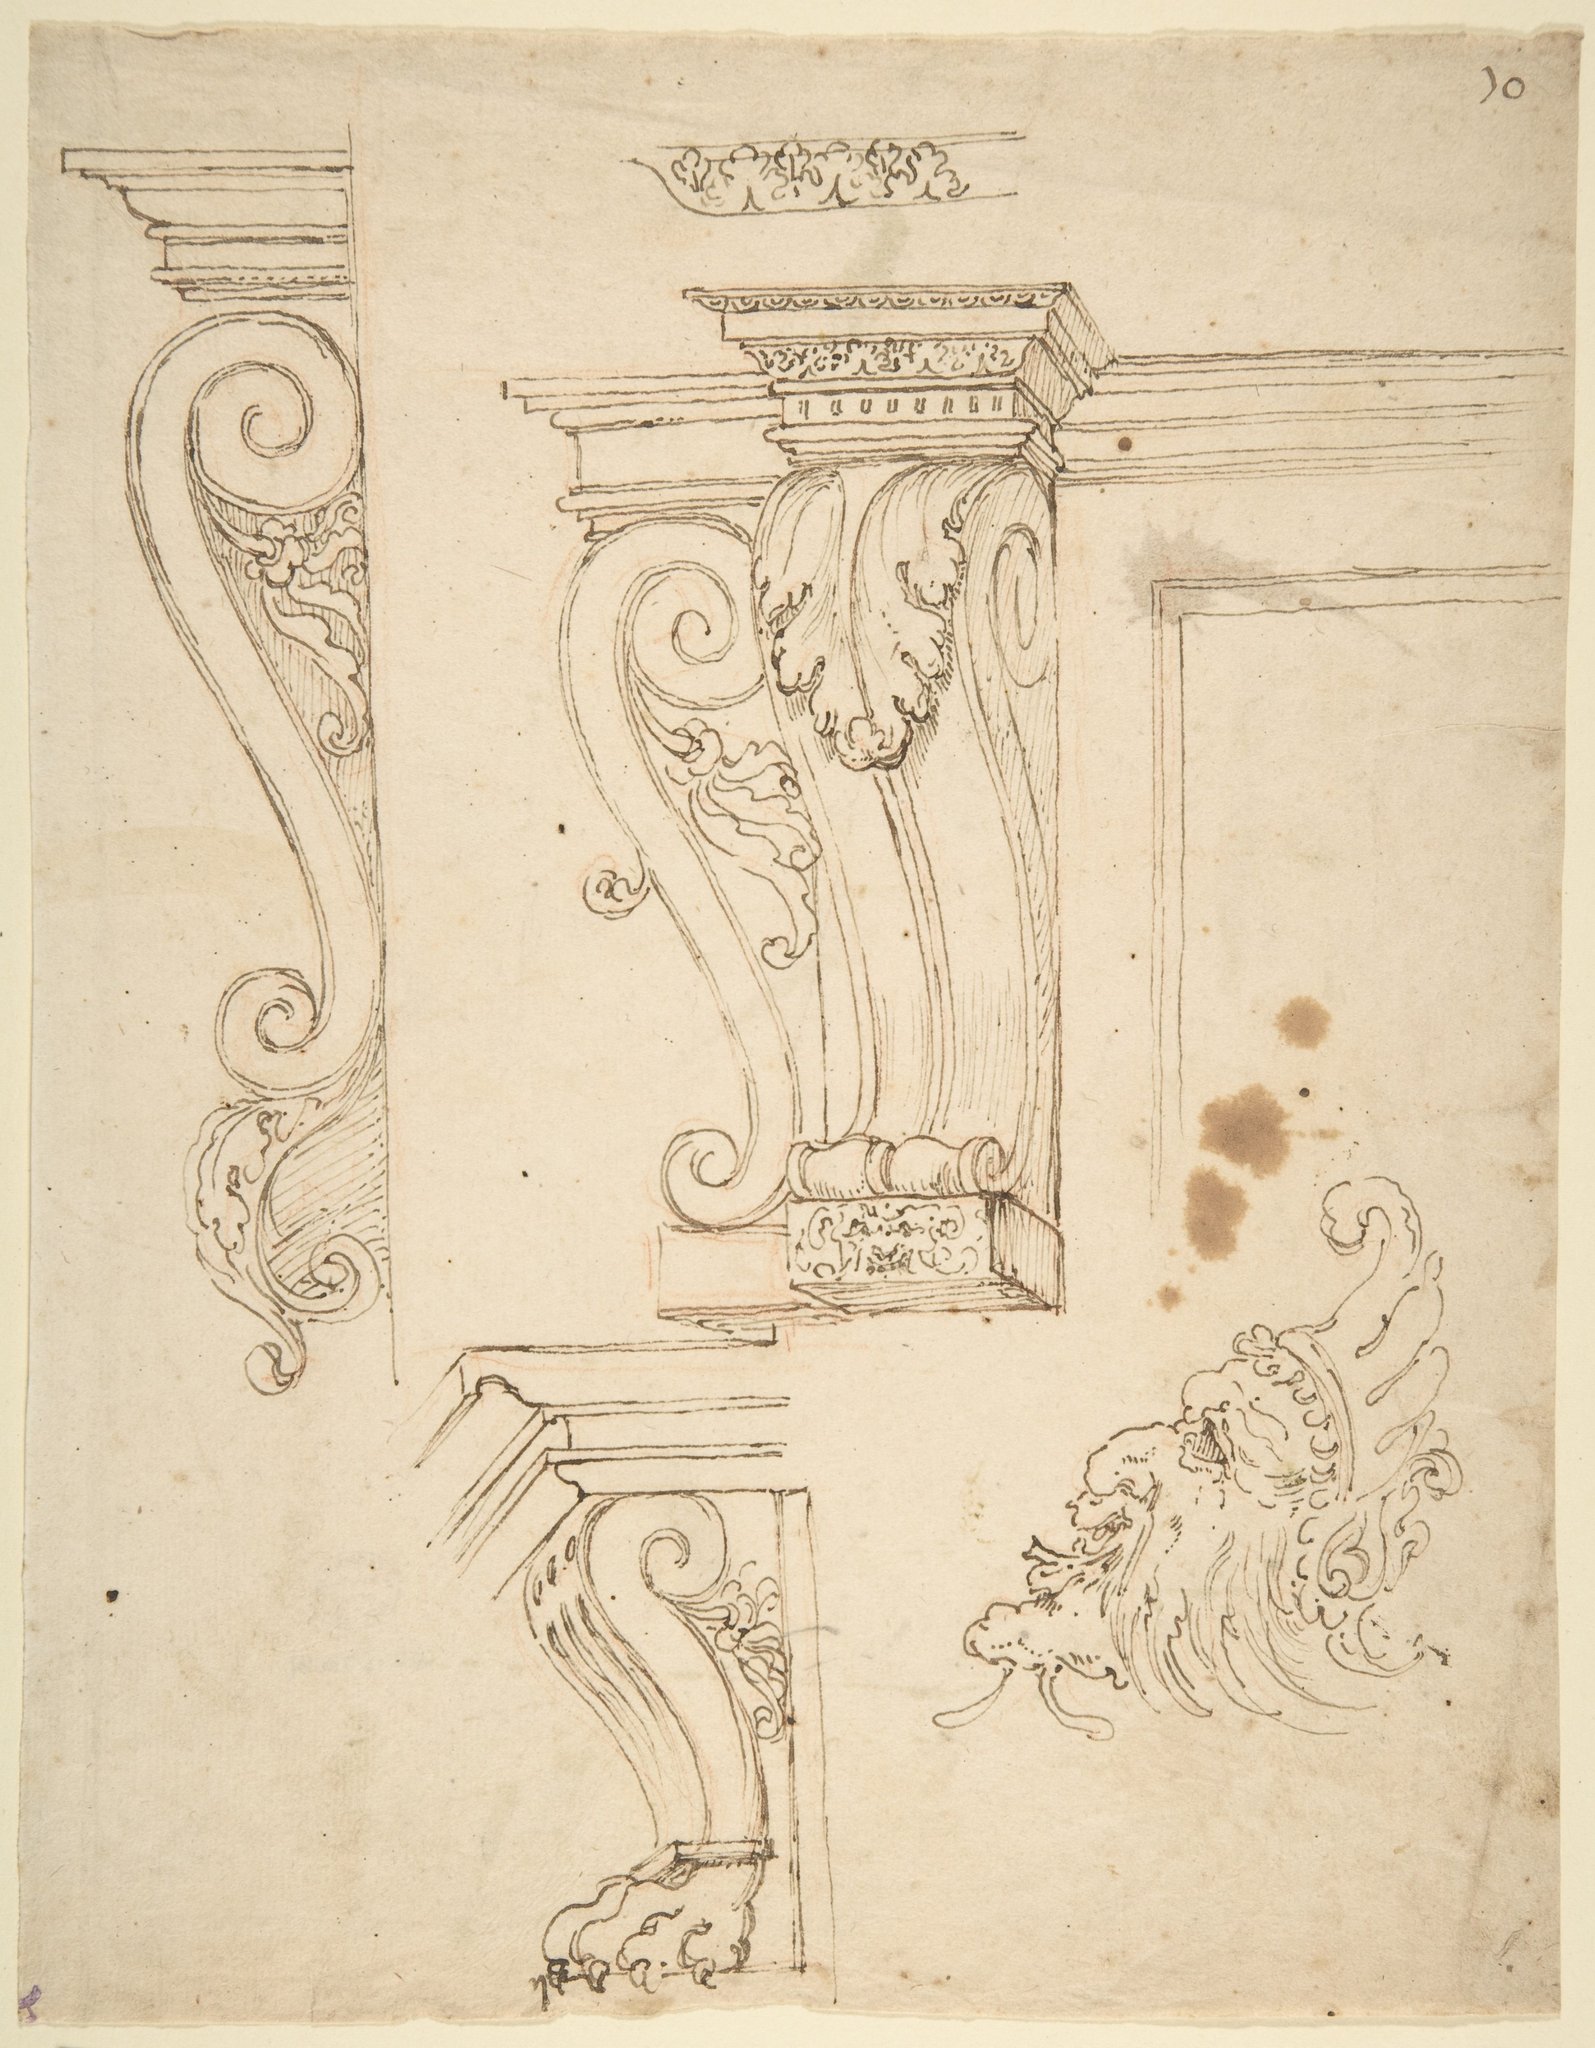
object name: drawing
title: Four Studies of Consoles and a Mask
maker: anonymous, italian, 16th century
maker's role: artist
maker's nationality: italian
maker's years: 1500-1600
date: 1501-1600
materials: ink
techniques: pen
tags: architecture,masks